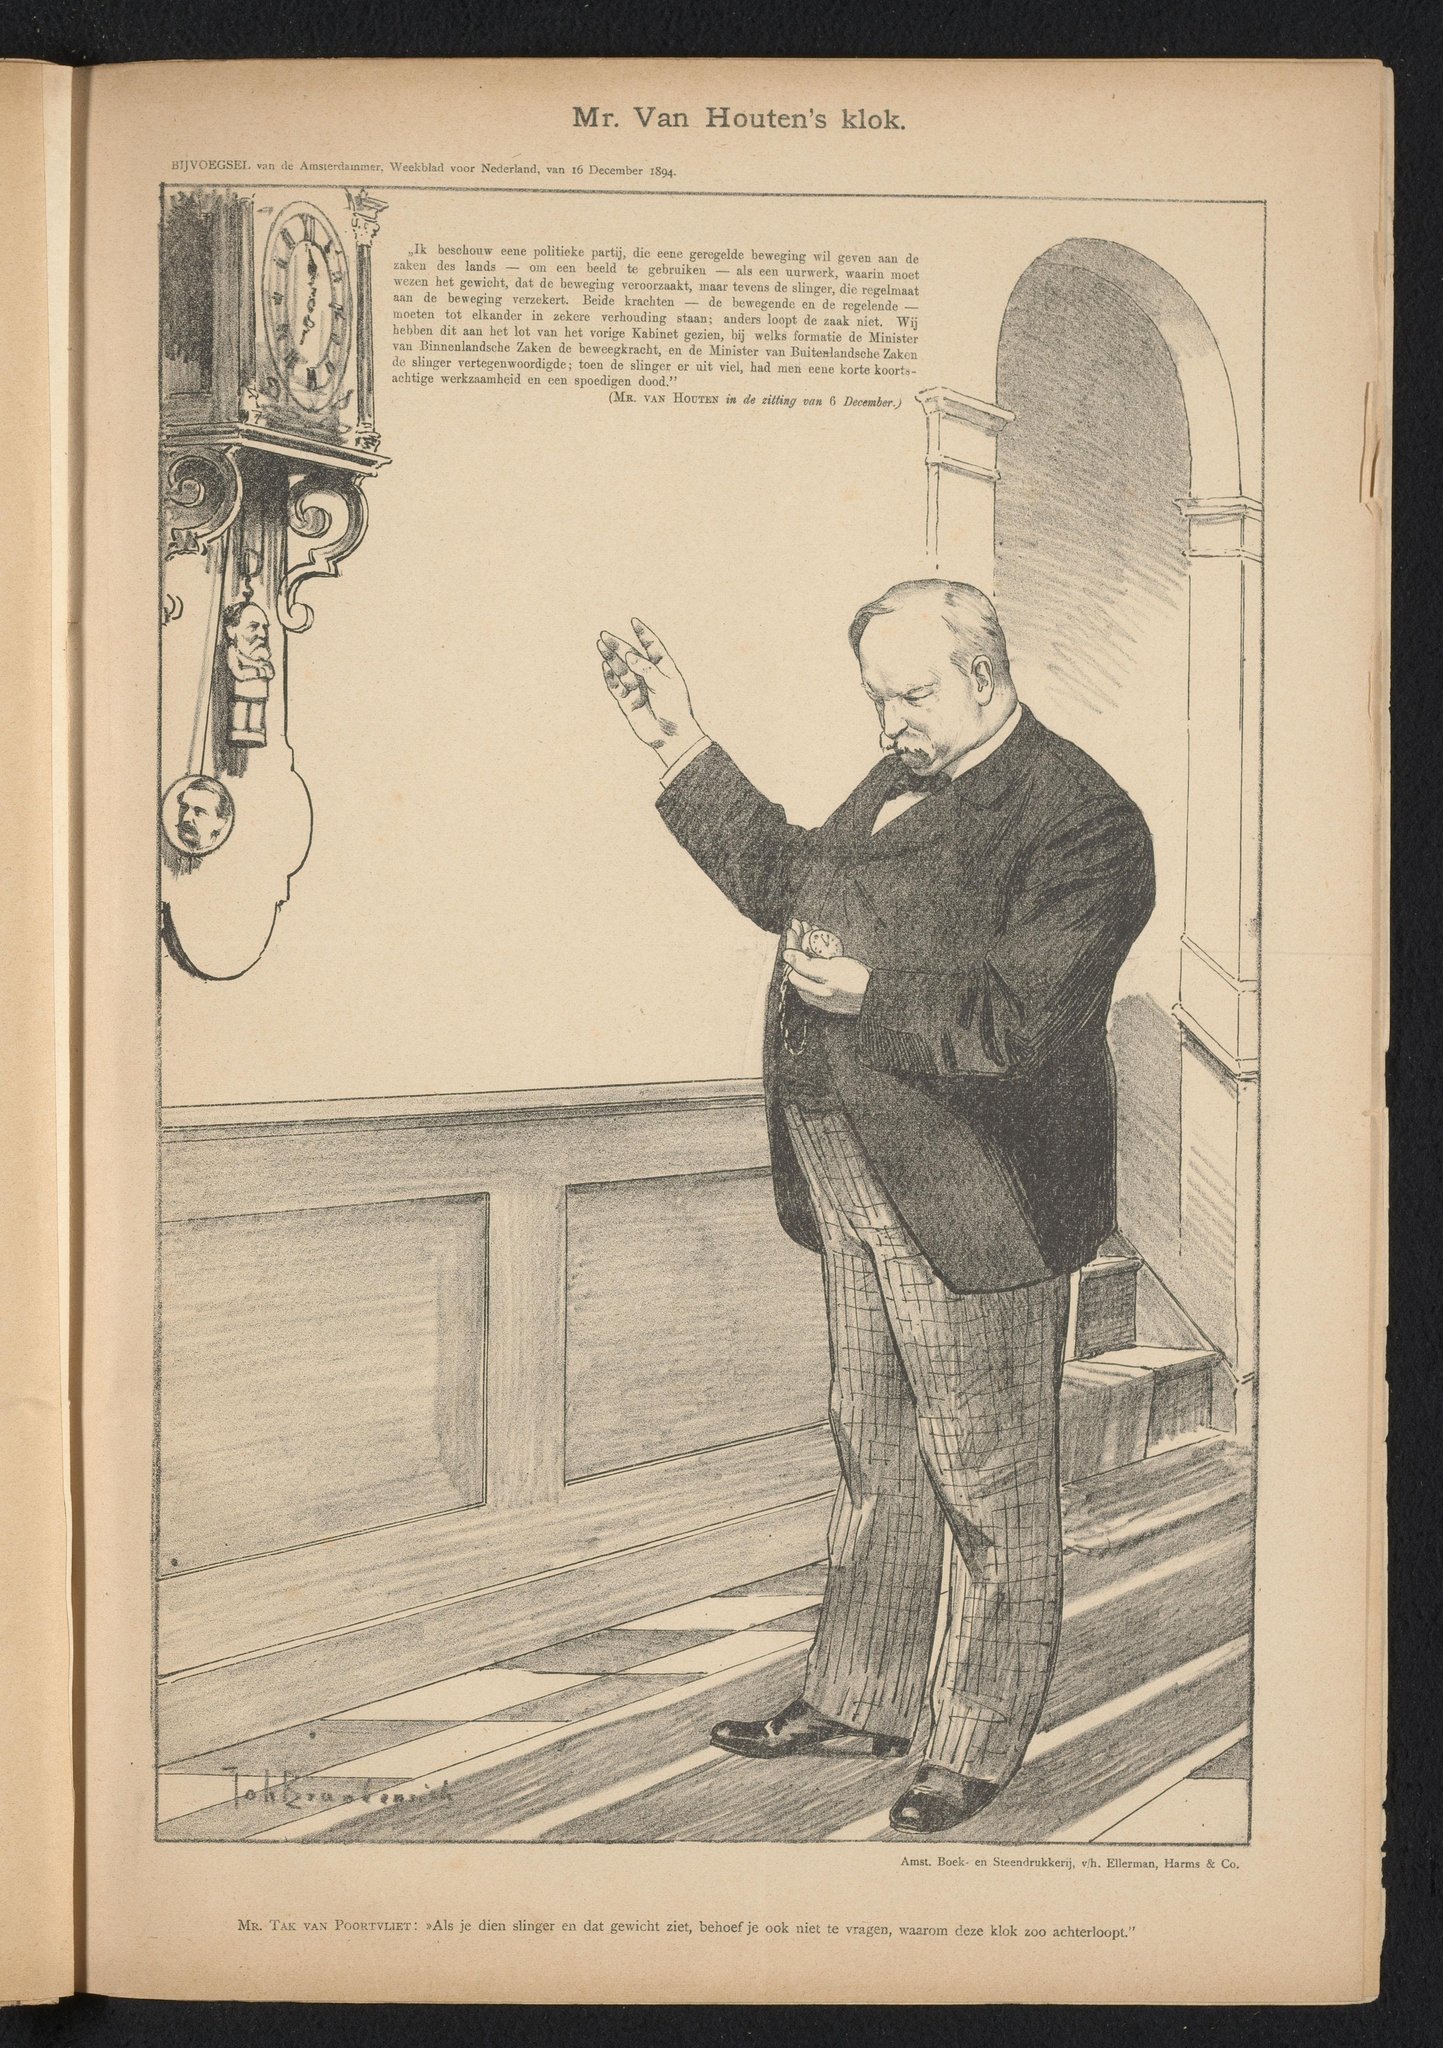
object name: cartoon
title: Mr. Van Houten's klok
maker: johan braakensiek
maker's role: draughtsman, print maker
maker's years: 1858-1940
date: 1894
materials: paper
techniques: lithograph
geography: amsterdam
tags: haarlem, the hague, politician, samuel van houten, minister ~ government, clock, watch, political caricatures and satires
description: Voormalig minister Tak van Poortvliet controleert met zijn horloge of een slingeruurwerk goed loopt. Op de slinger het hoofd van premier Joan Roëll, op het gewicht minister Sam van Houten.